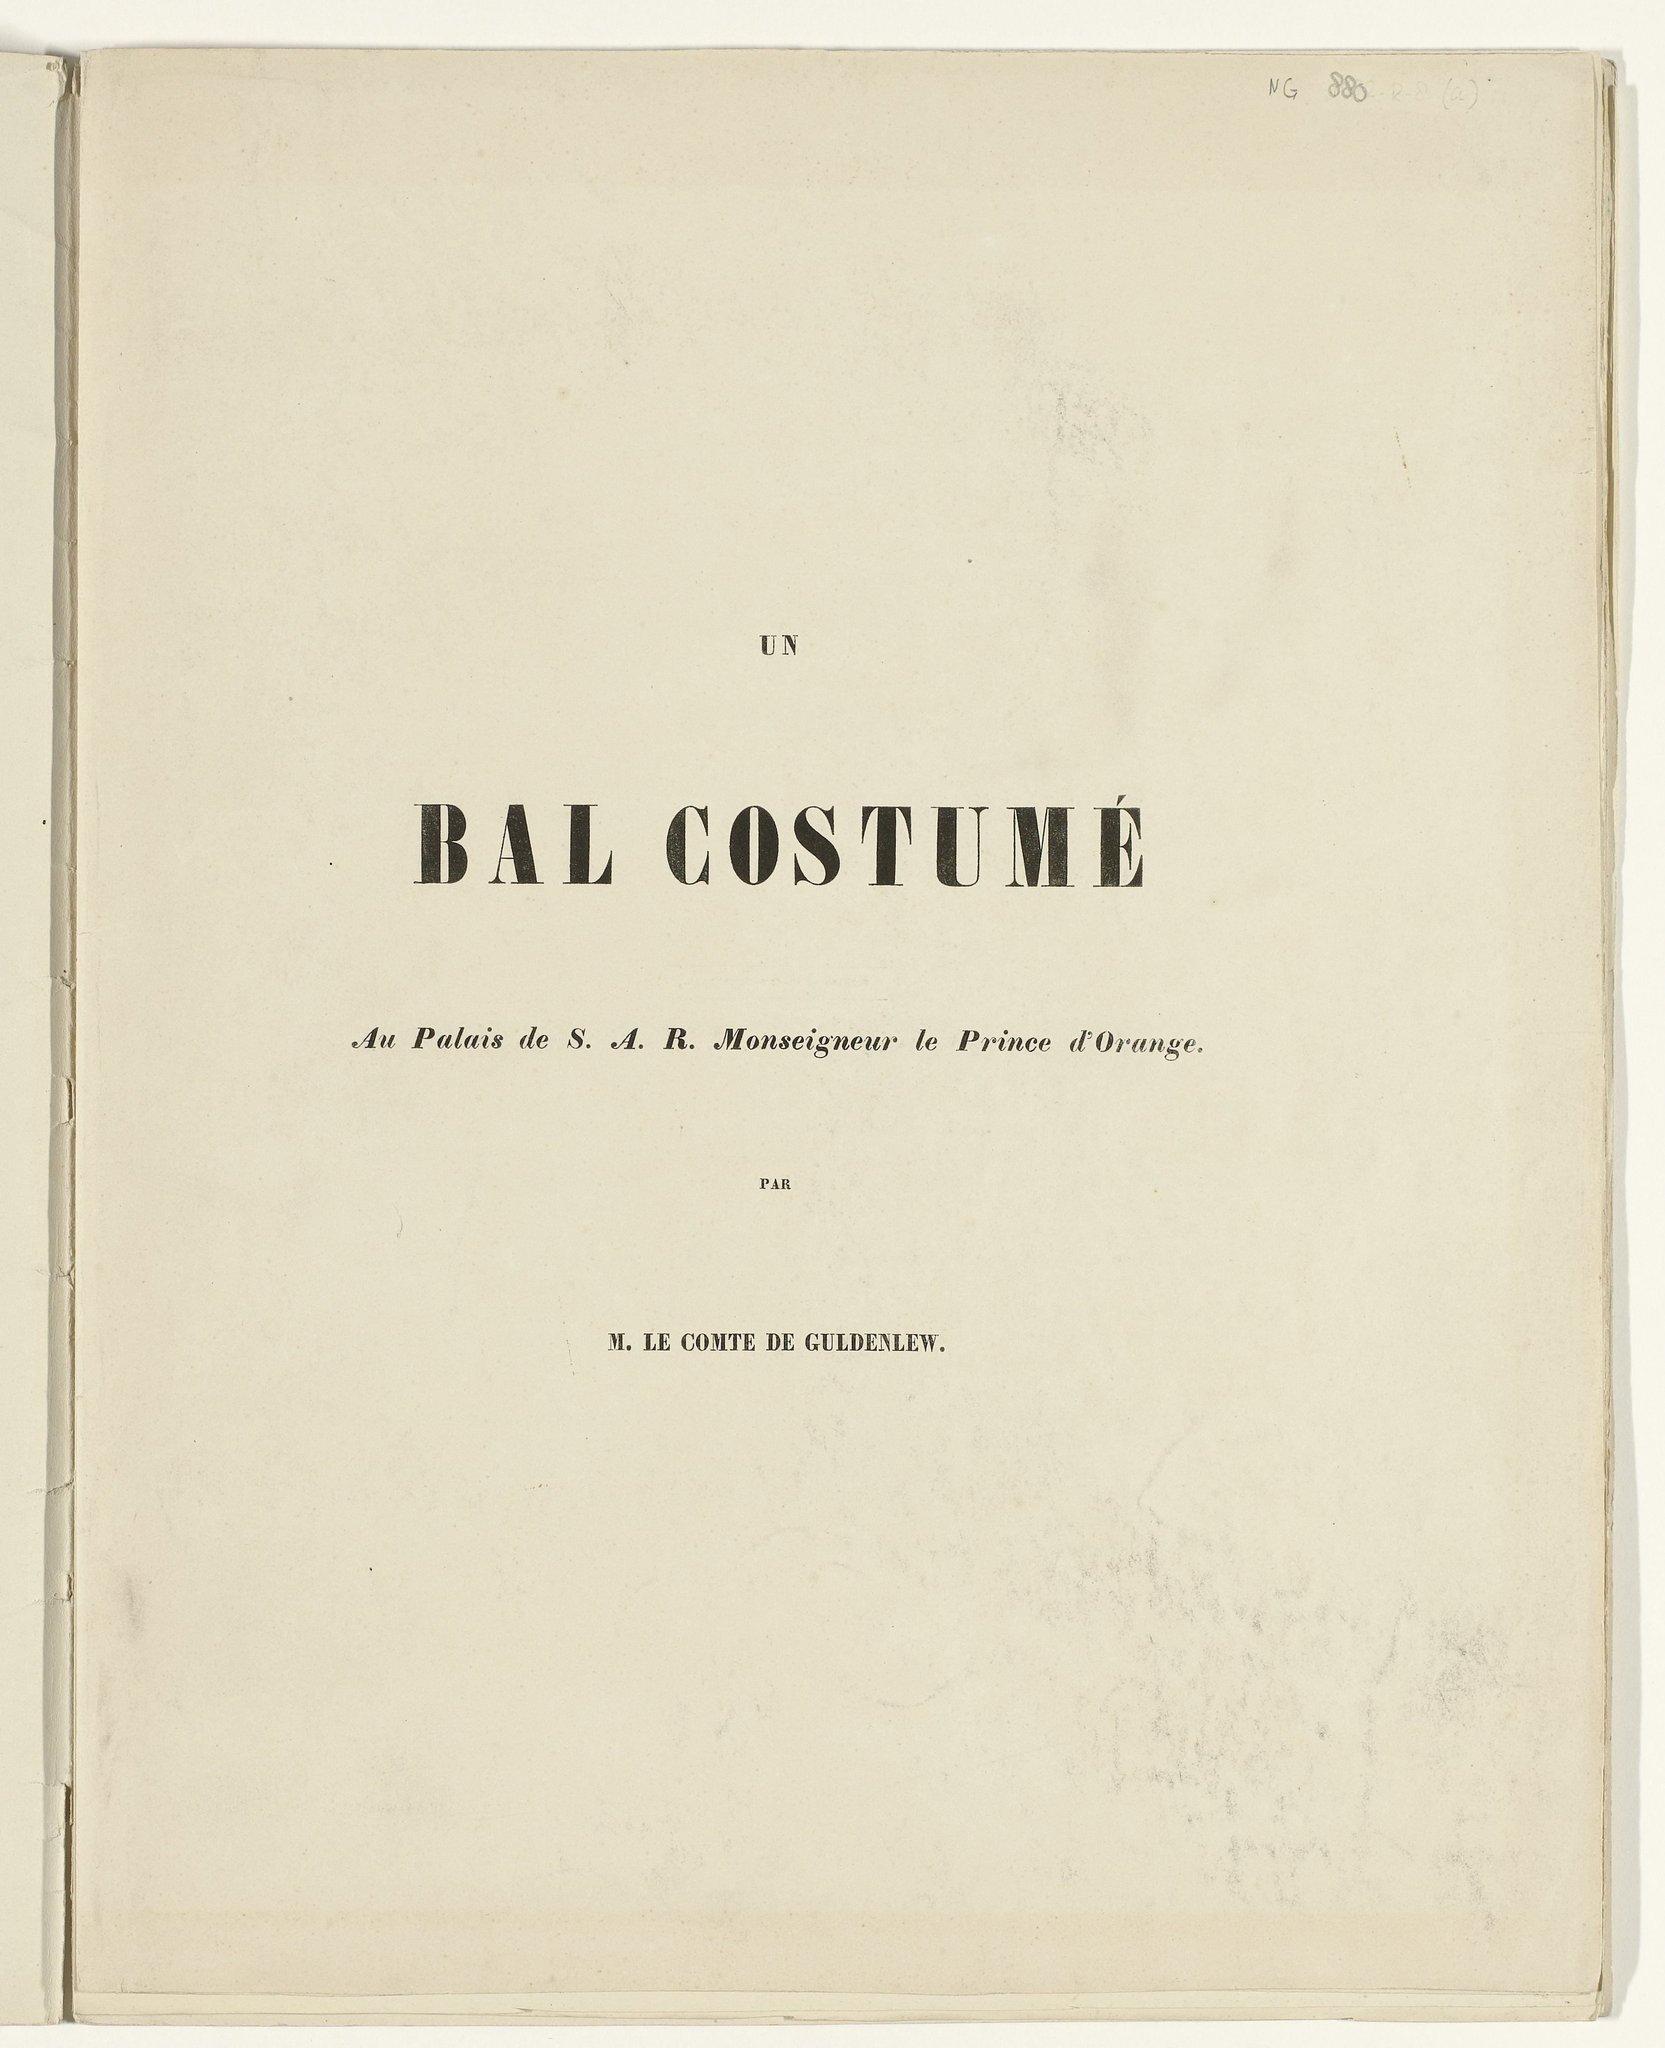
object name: text sheet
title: Tekst uit: Le Bal Costumé donné au Palais de S.A.R. Monseigneur le Prince d'Orange au 26 Fevrier 1845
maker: le comte de guldenlew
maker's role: schrijver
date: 1845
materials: paper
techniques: letterpress printing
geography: the hague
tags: brussels, willem iii (koning der nederlanden)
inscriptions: date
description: Tekst met een deel van de beschrijving van het gekostumeerd bal gehouden op het paleis van de prins van Oranje (de latere koning Willem III) in Den Haag op 26 februari 1845, titel-p. 2.